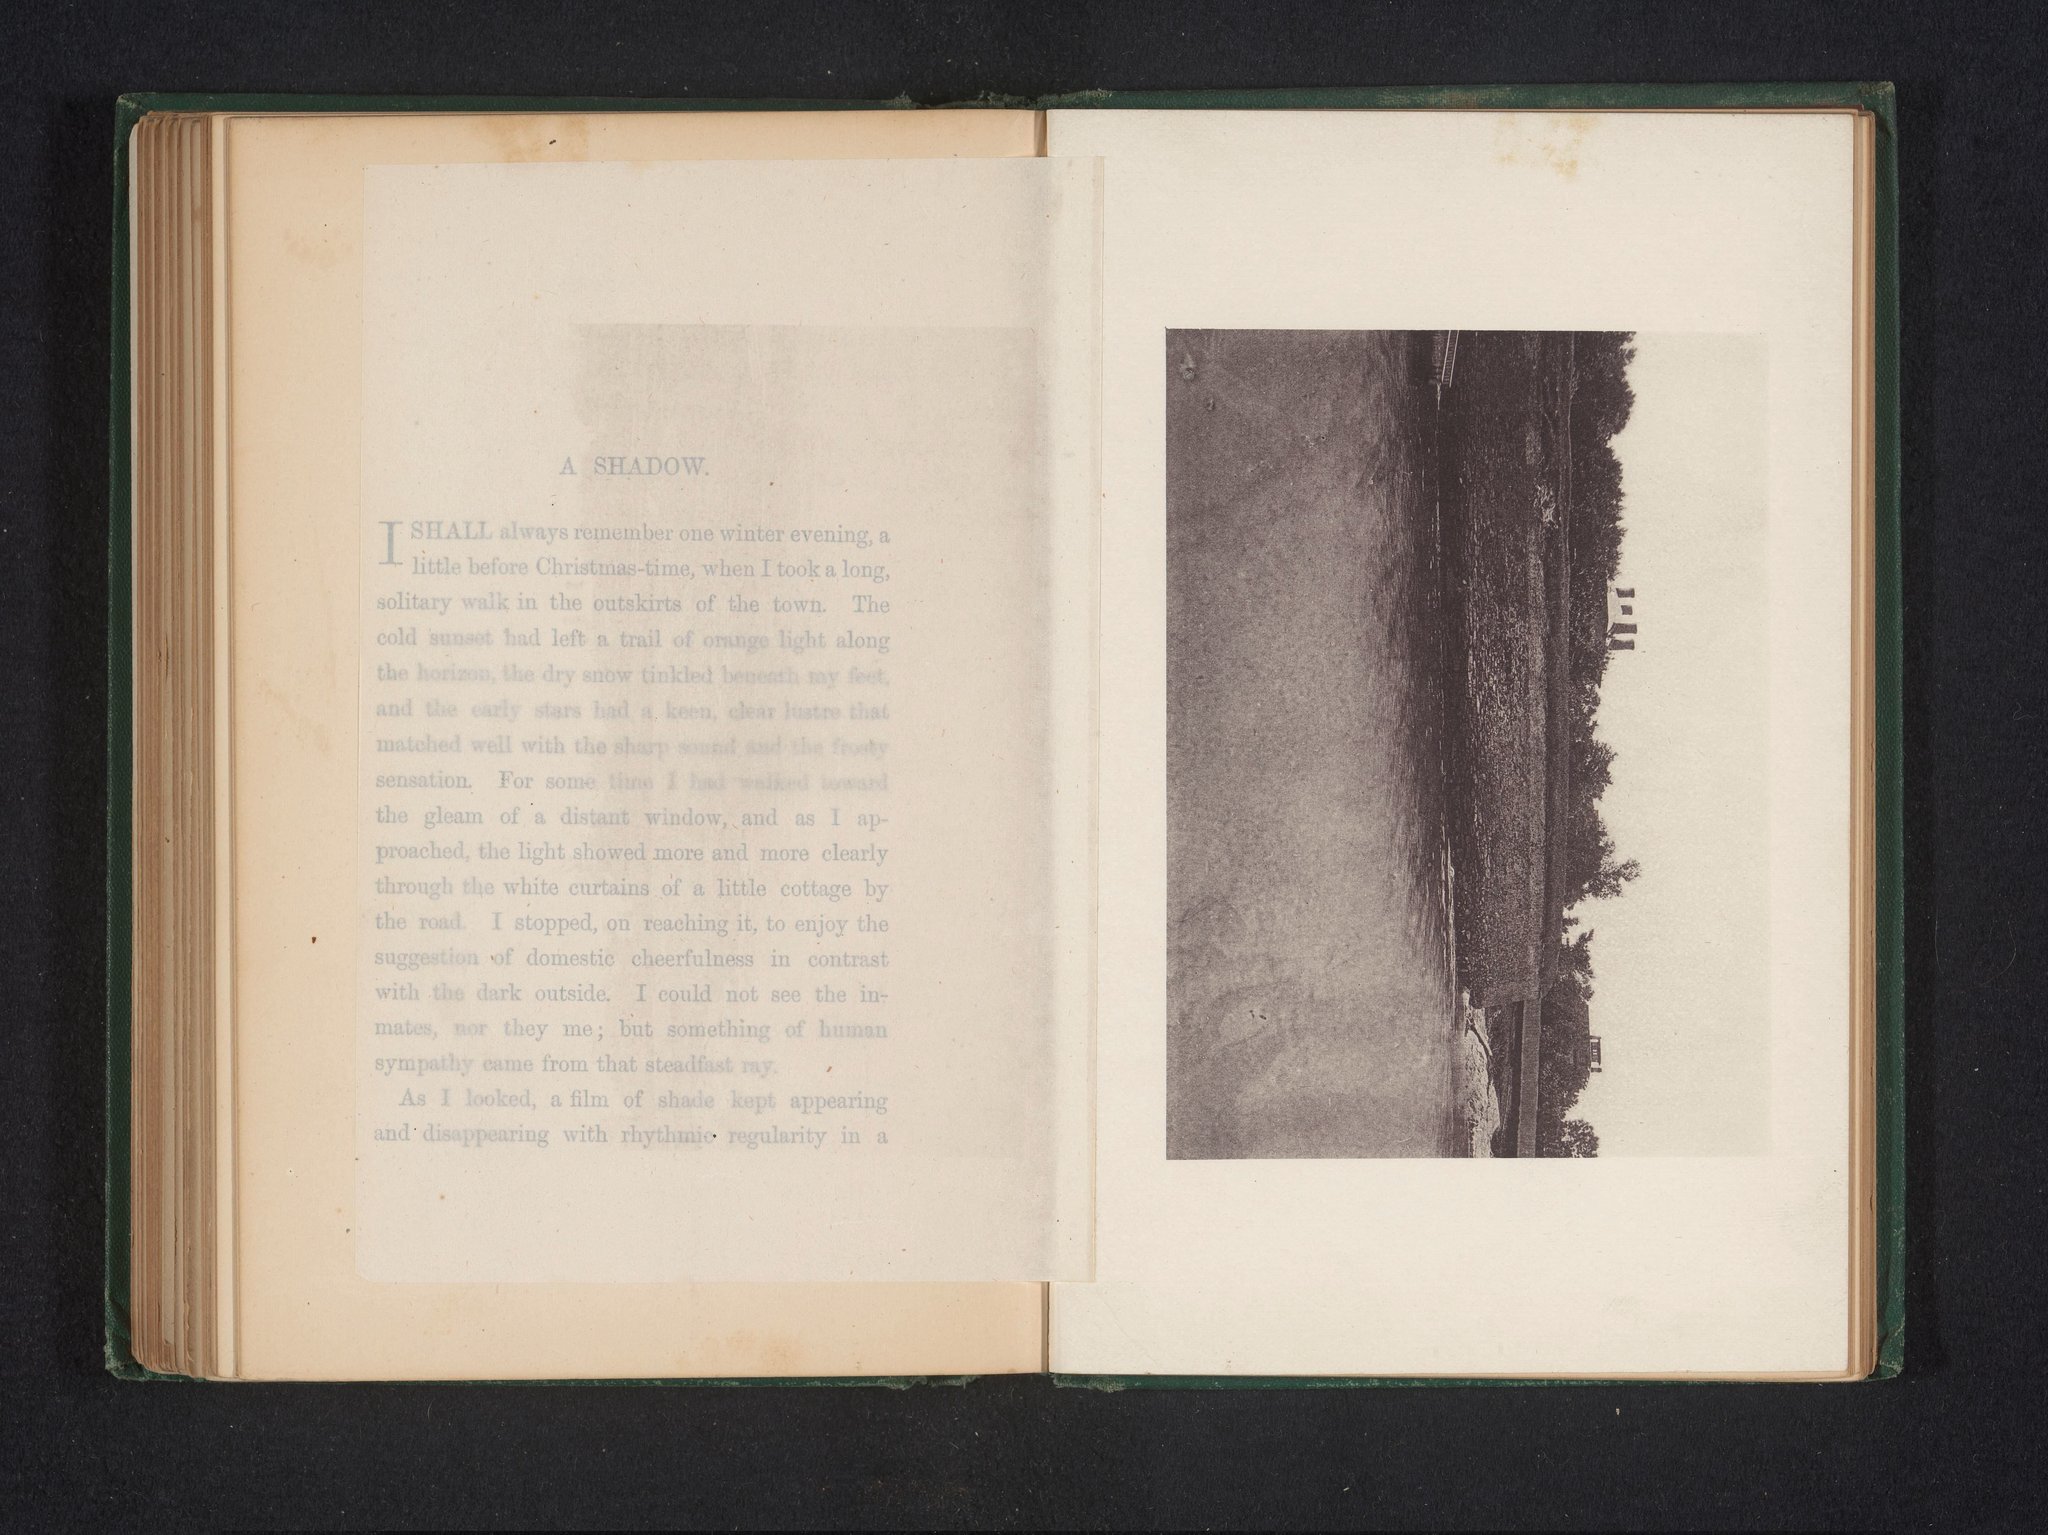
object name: photomechanical print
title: Gezicht op Fort Greene te Newport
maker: Anonymous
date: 1868-1873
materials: paper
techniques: photograph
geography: newport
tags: fortress